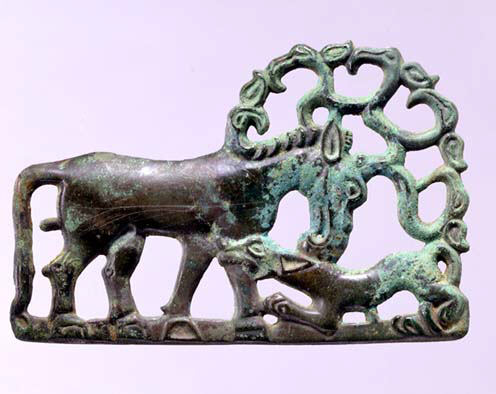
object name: belt buckle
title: Belt Buckle with Animal-Combat Scene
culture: north chinese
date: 300-101 BCE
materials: bronze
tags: animals